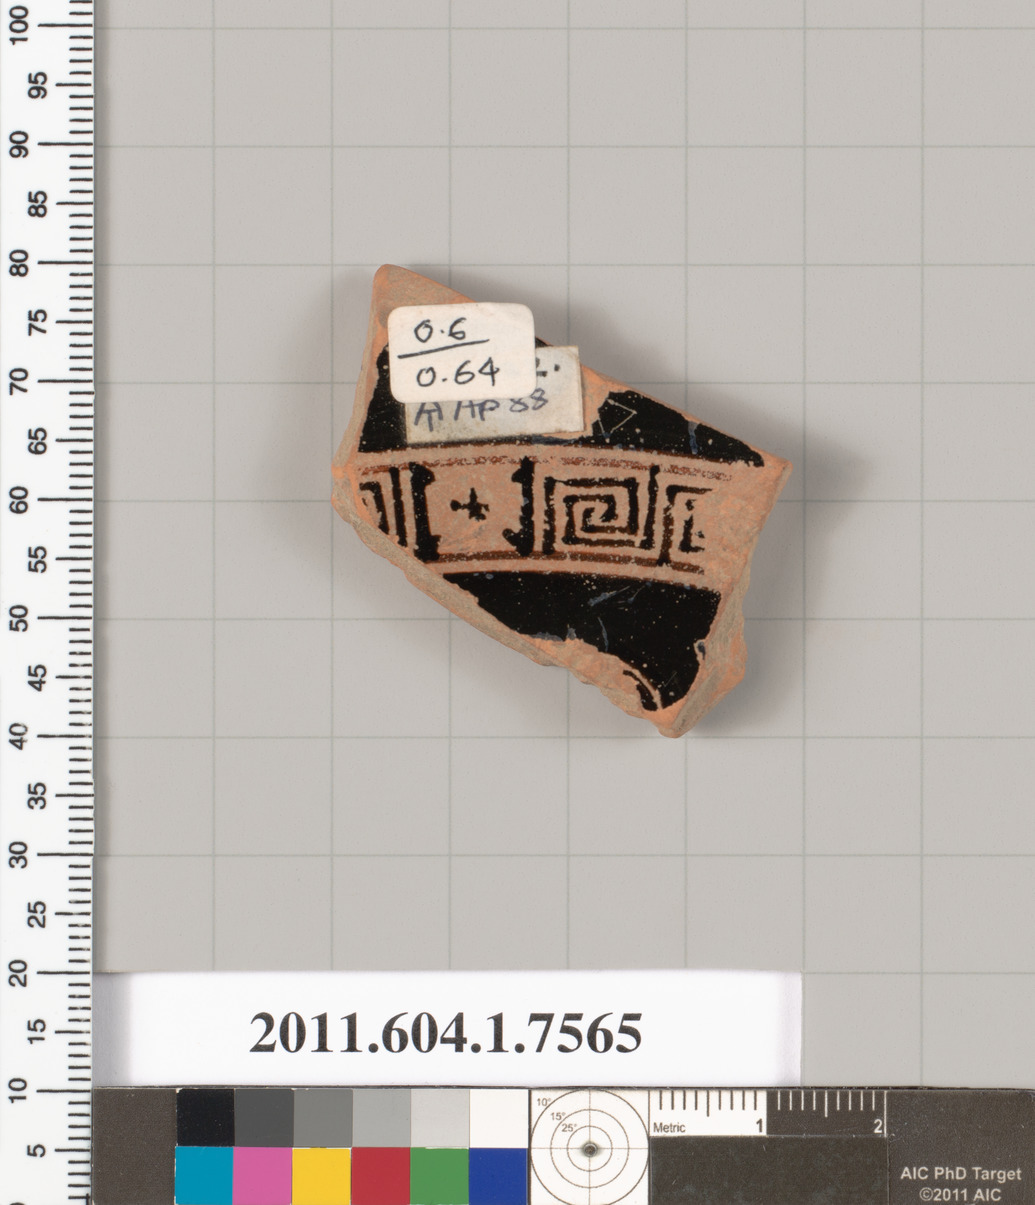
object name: kylix fragment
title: Terracotta fragment of a kylix (drinking cup)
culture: greek, attic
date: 460-450 BCE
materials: terracotta